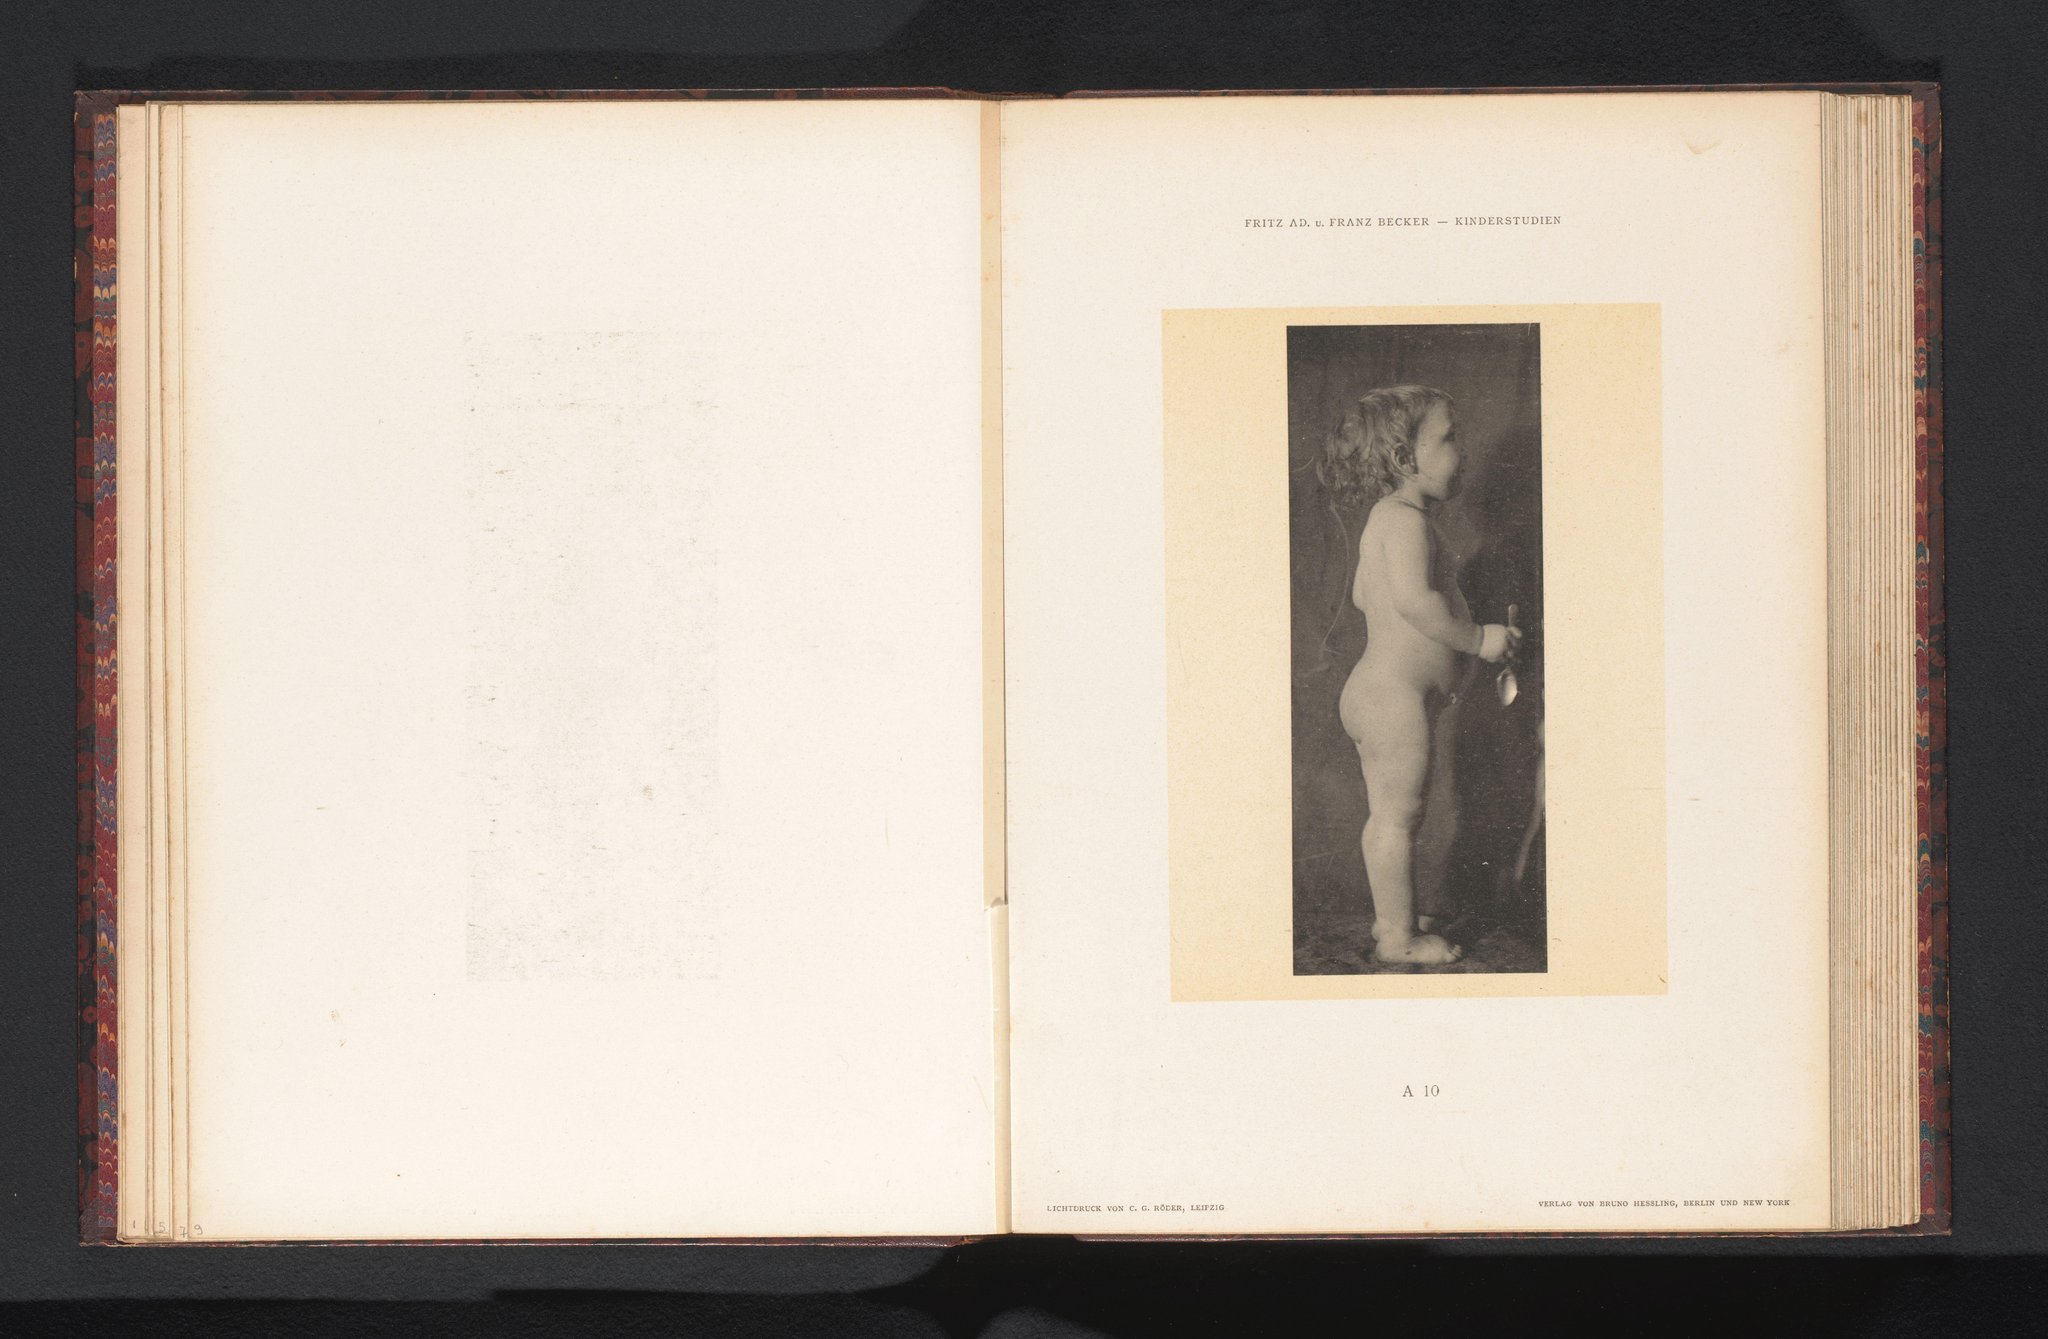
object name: page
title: Staand naakt meisje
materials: paper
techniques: photograph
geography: new york city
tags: standing figure - aa - female human figure (+ sideview, profile), toddler (female)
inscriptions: number: ‘A 10’